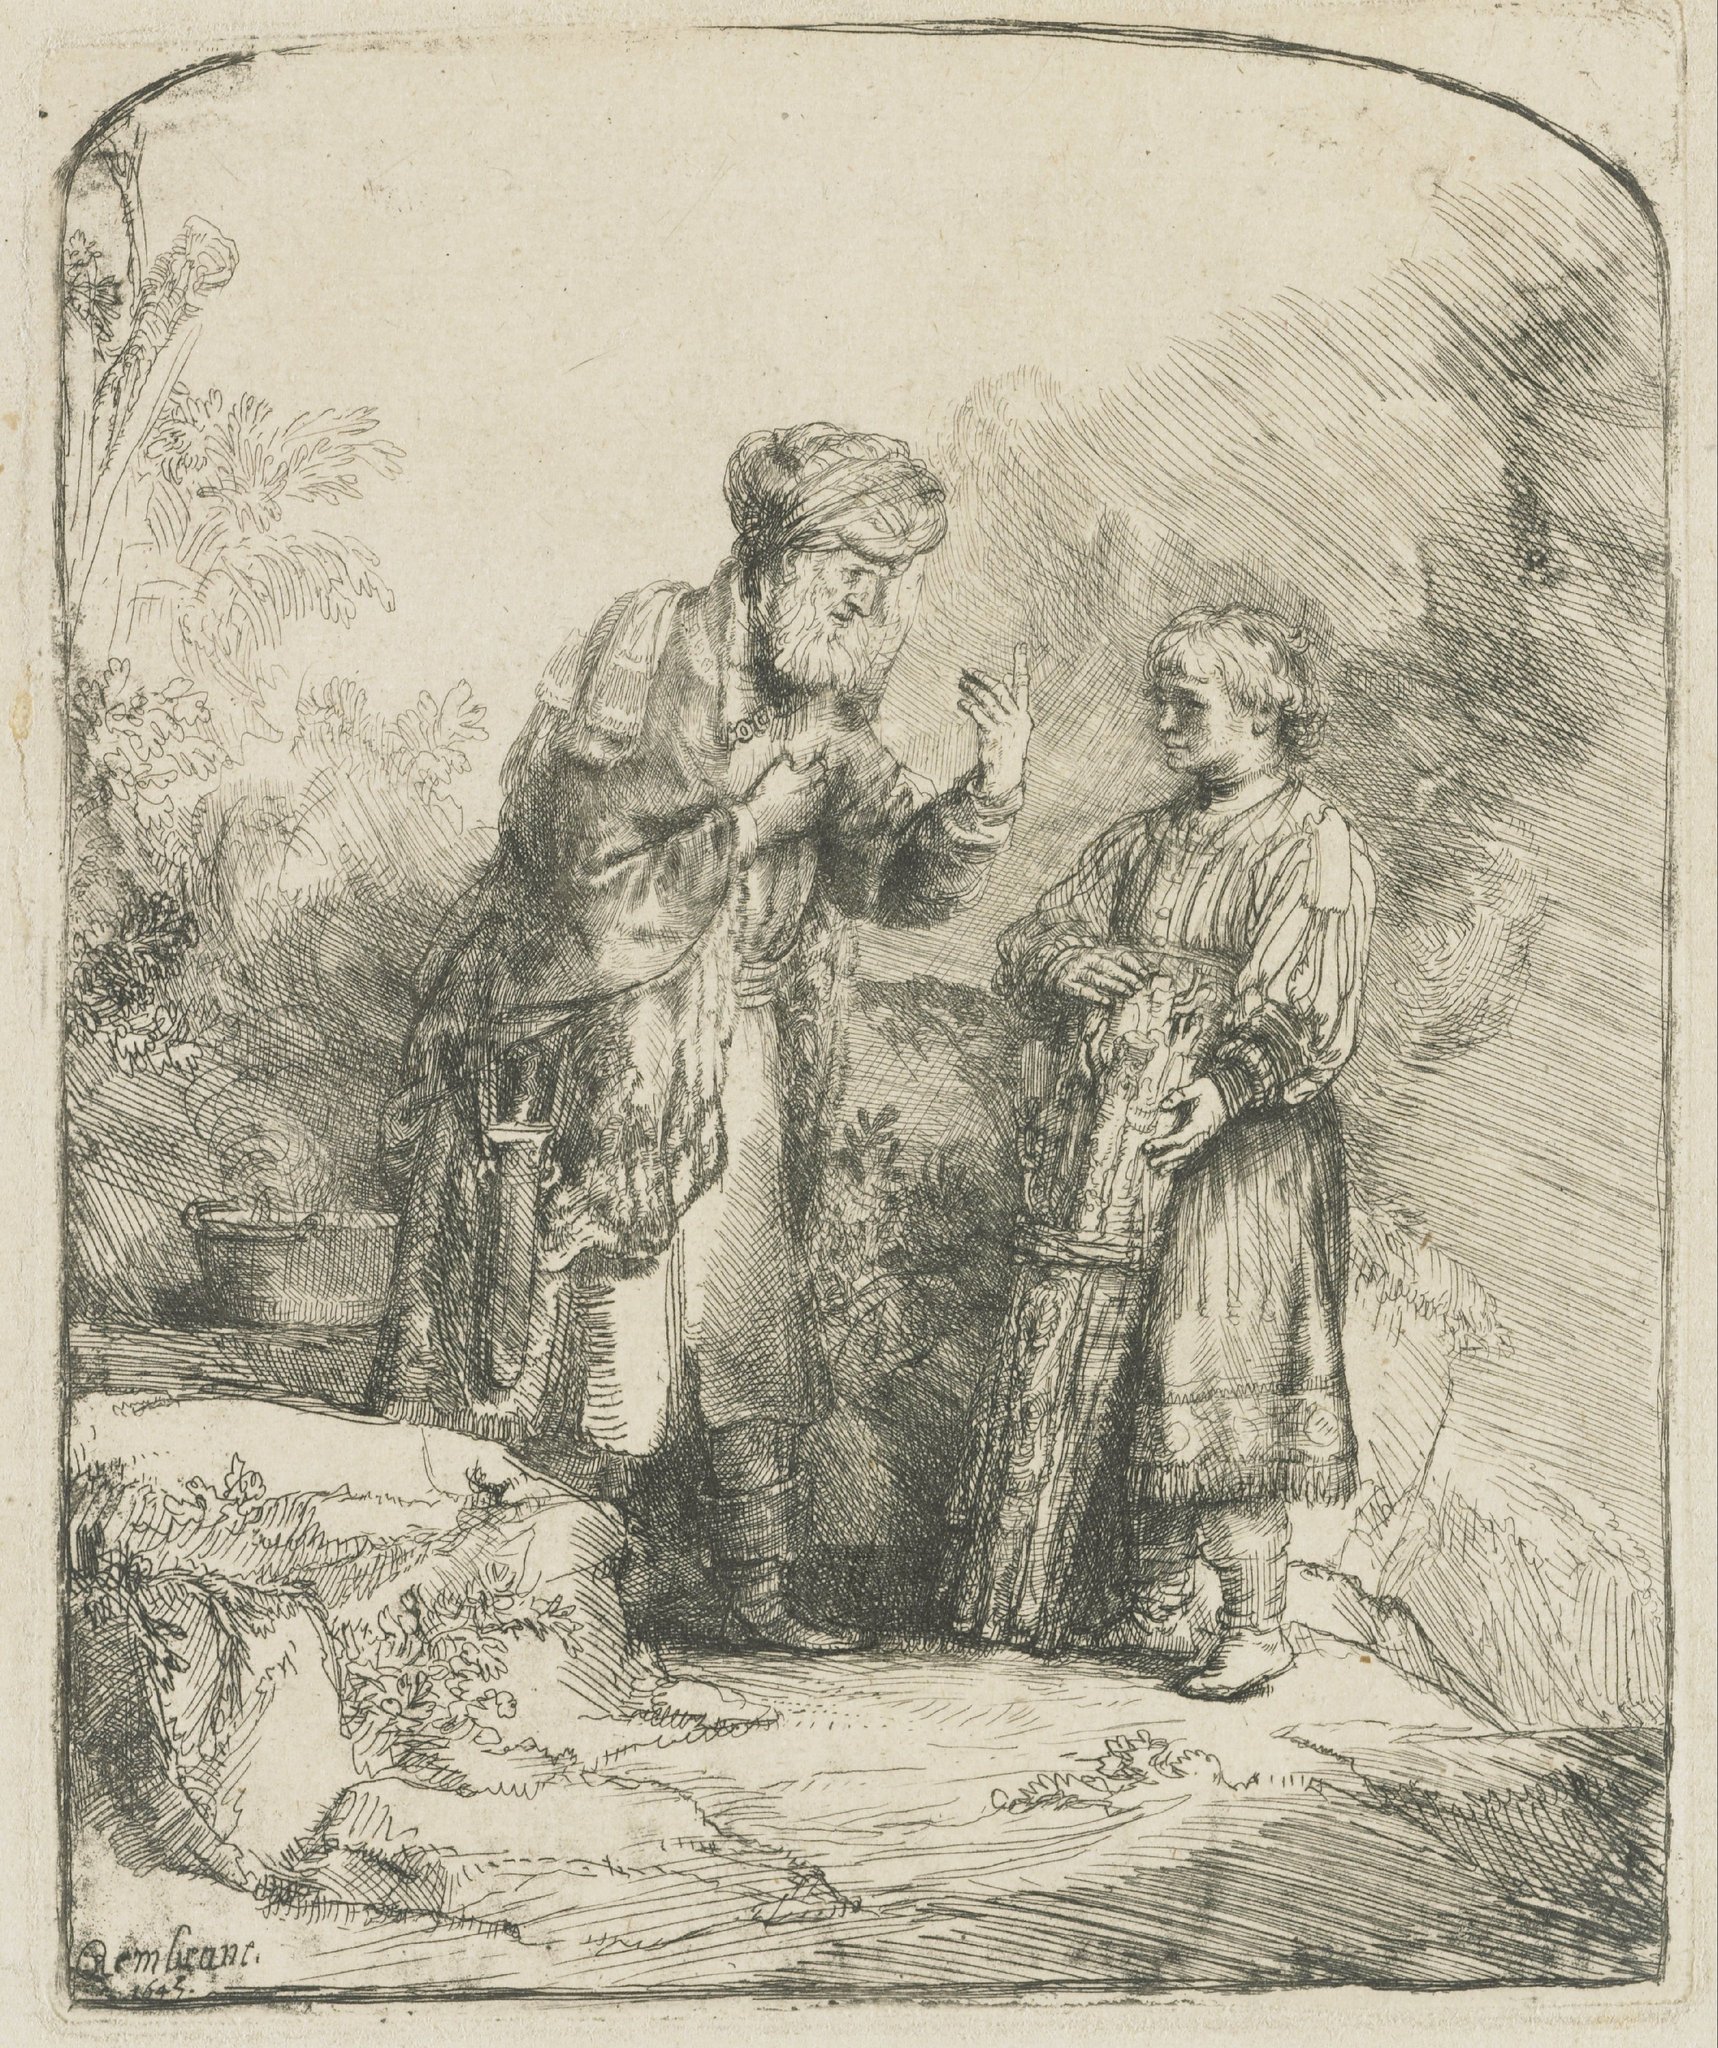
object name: print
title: Abraham and Isaac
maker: rembrandt van rijn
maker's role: draughtsman, painter, print maker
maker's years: 1606-1669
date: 1645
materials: paper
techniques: drypoint, etching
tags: story of isaac, story of abraham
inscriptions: signature and date: ‘Rembrant.1645.’, collector's mark: Lugt 240